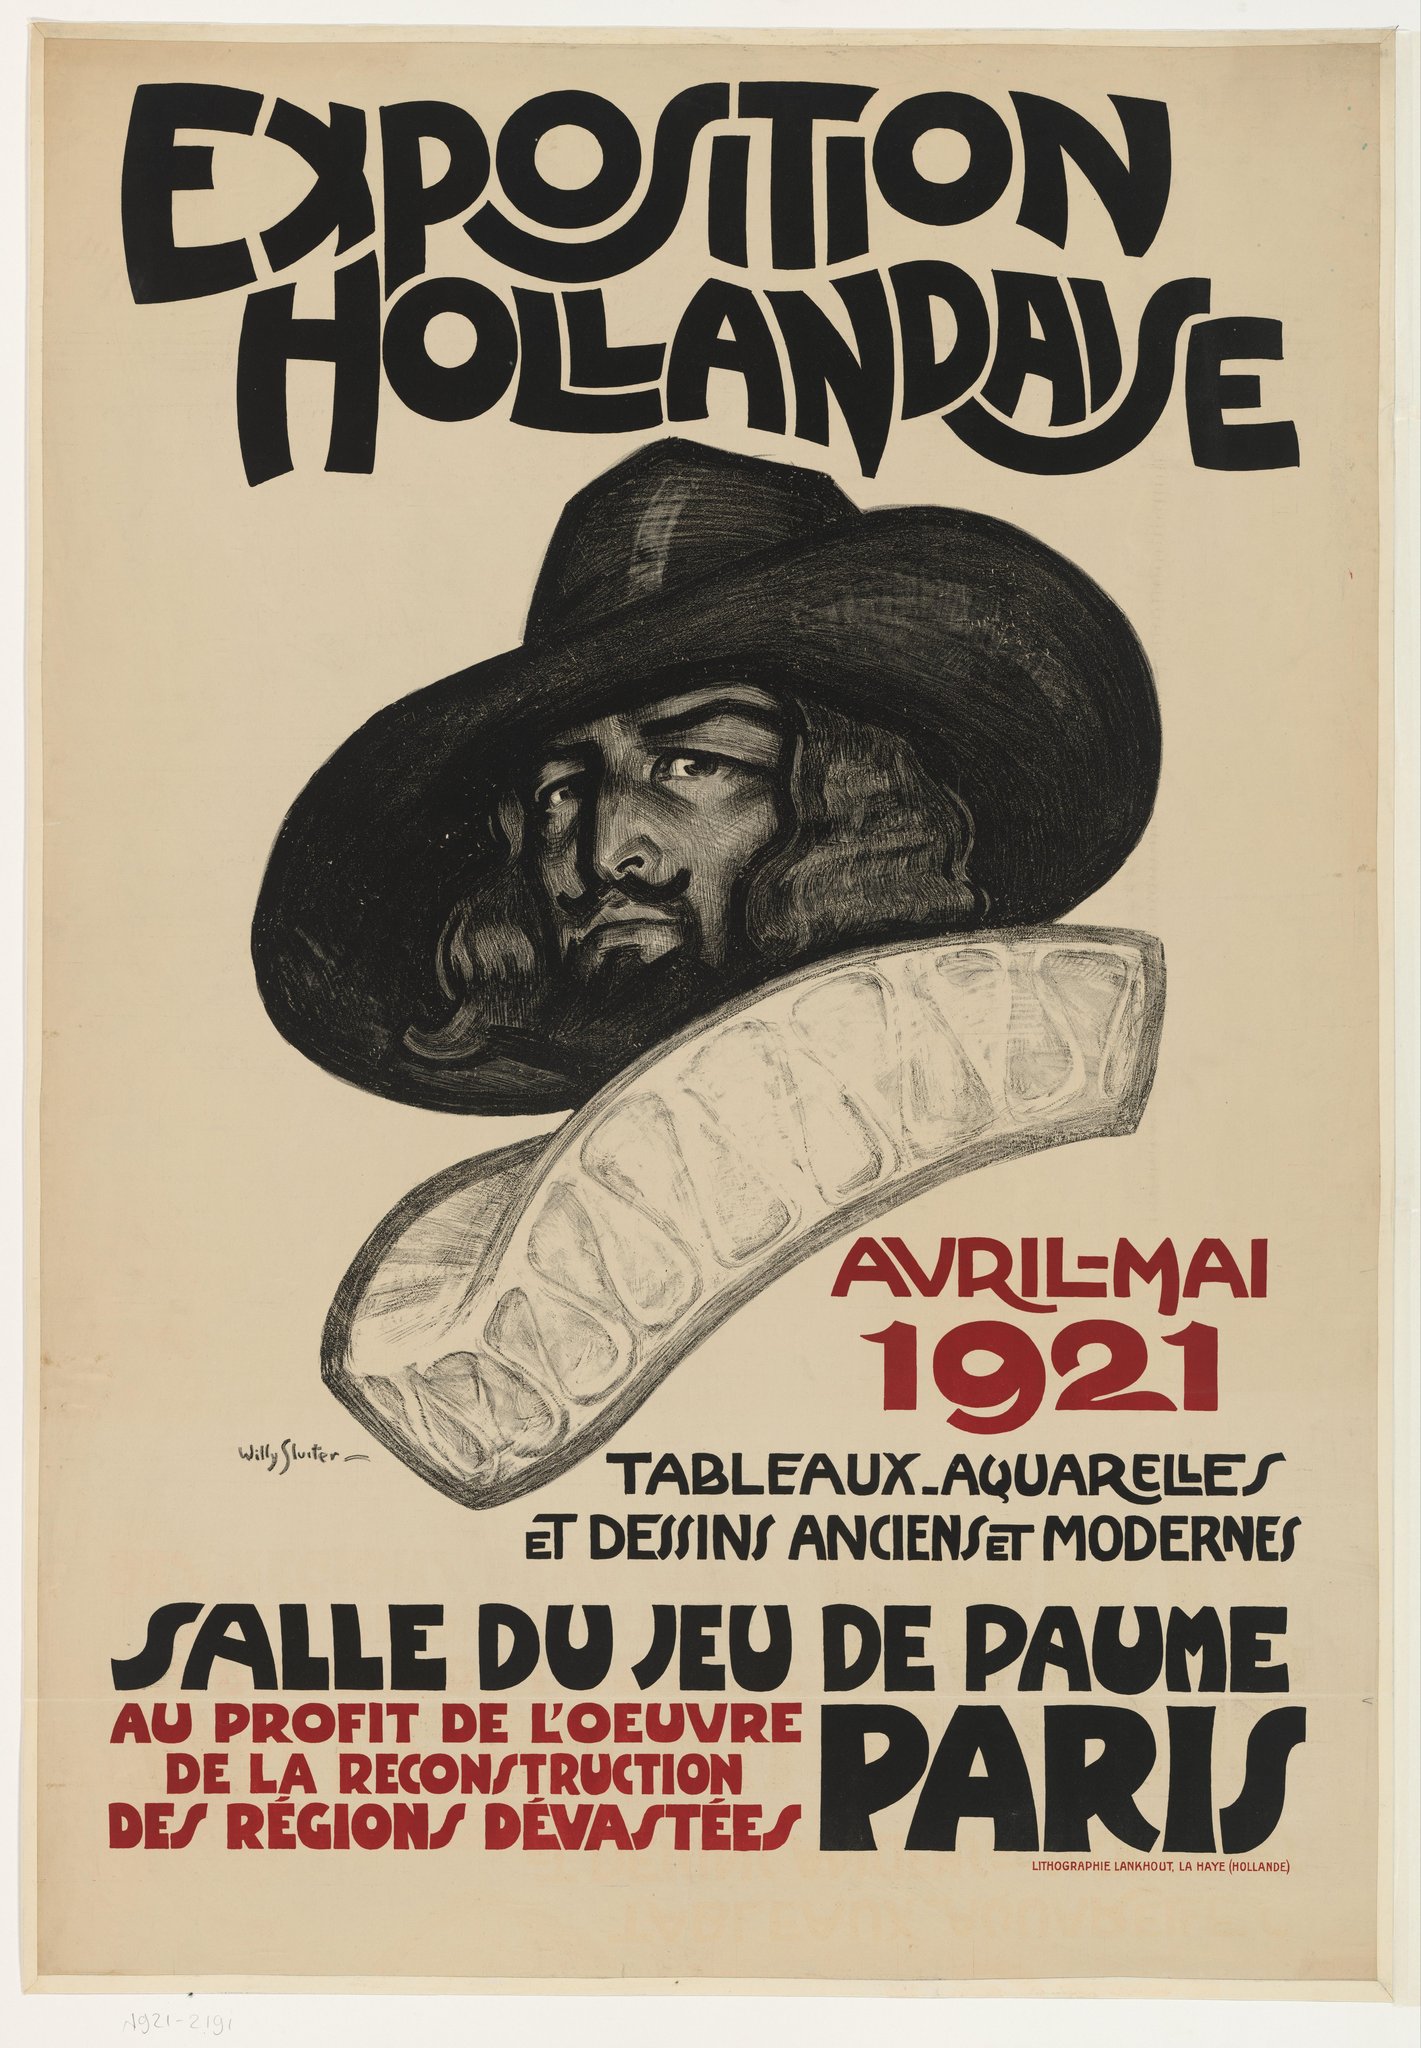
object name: poster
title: Affiche voor de Exposition Hollandaise te Parijs, 1921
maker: willy sluiter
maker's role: draughtsman, painter, print maker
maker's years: 1873-1949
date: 1921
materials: paper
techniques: lithograph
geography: the hague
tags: exhibition ~ art, historical persons not known by name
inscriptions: collector's mark: Lugt 2228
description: Tentoonstelling voor Nederlandse kunst, in april en mei 1921 gehouden in het Jeu de Paume gebouw in de Jardin des Tuileries.